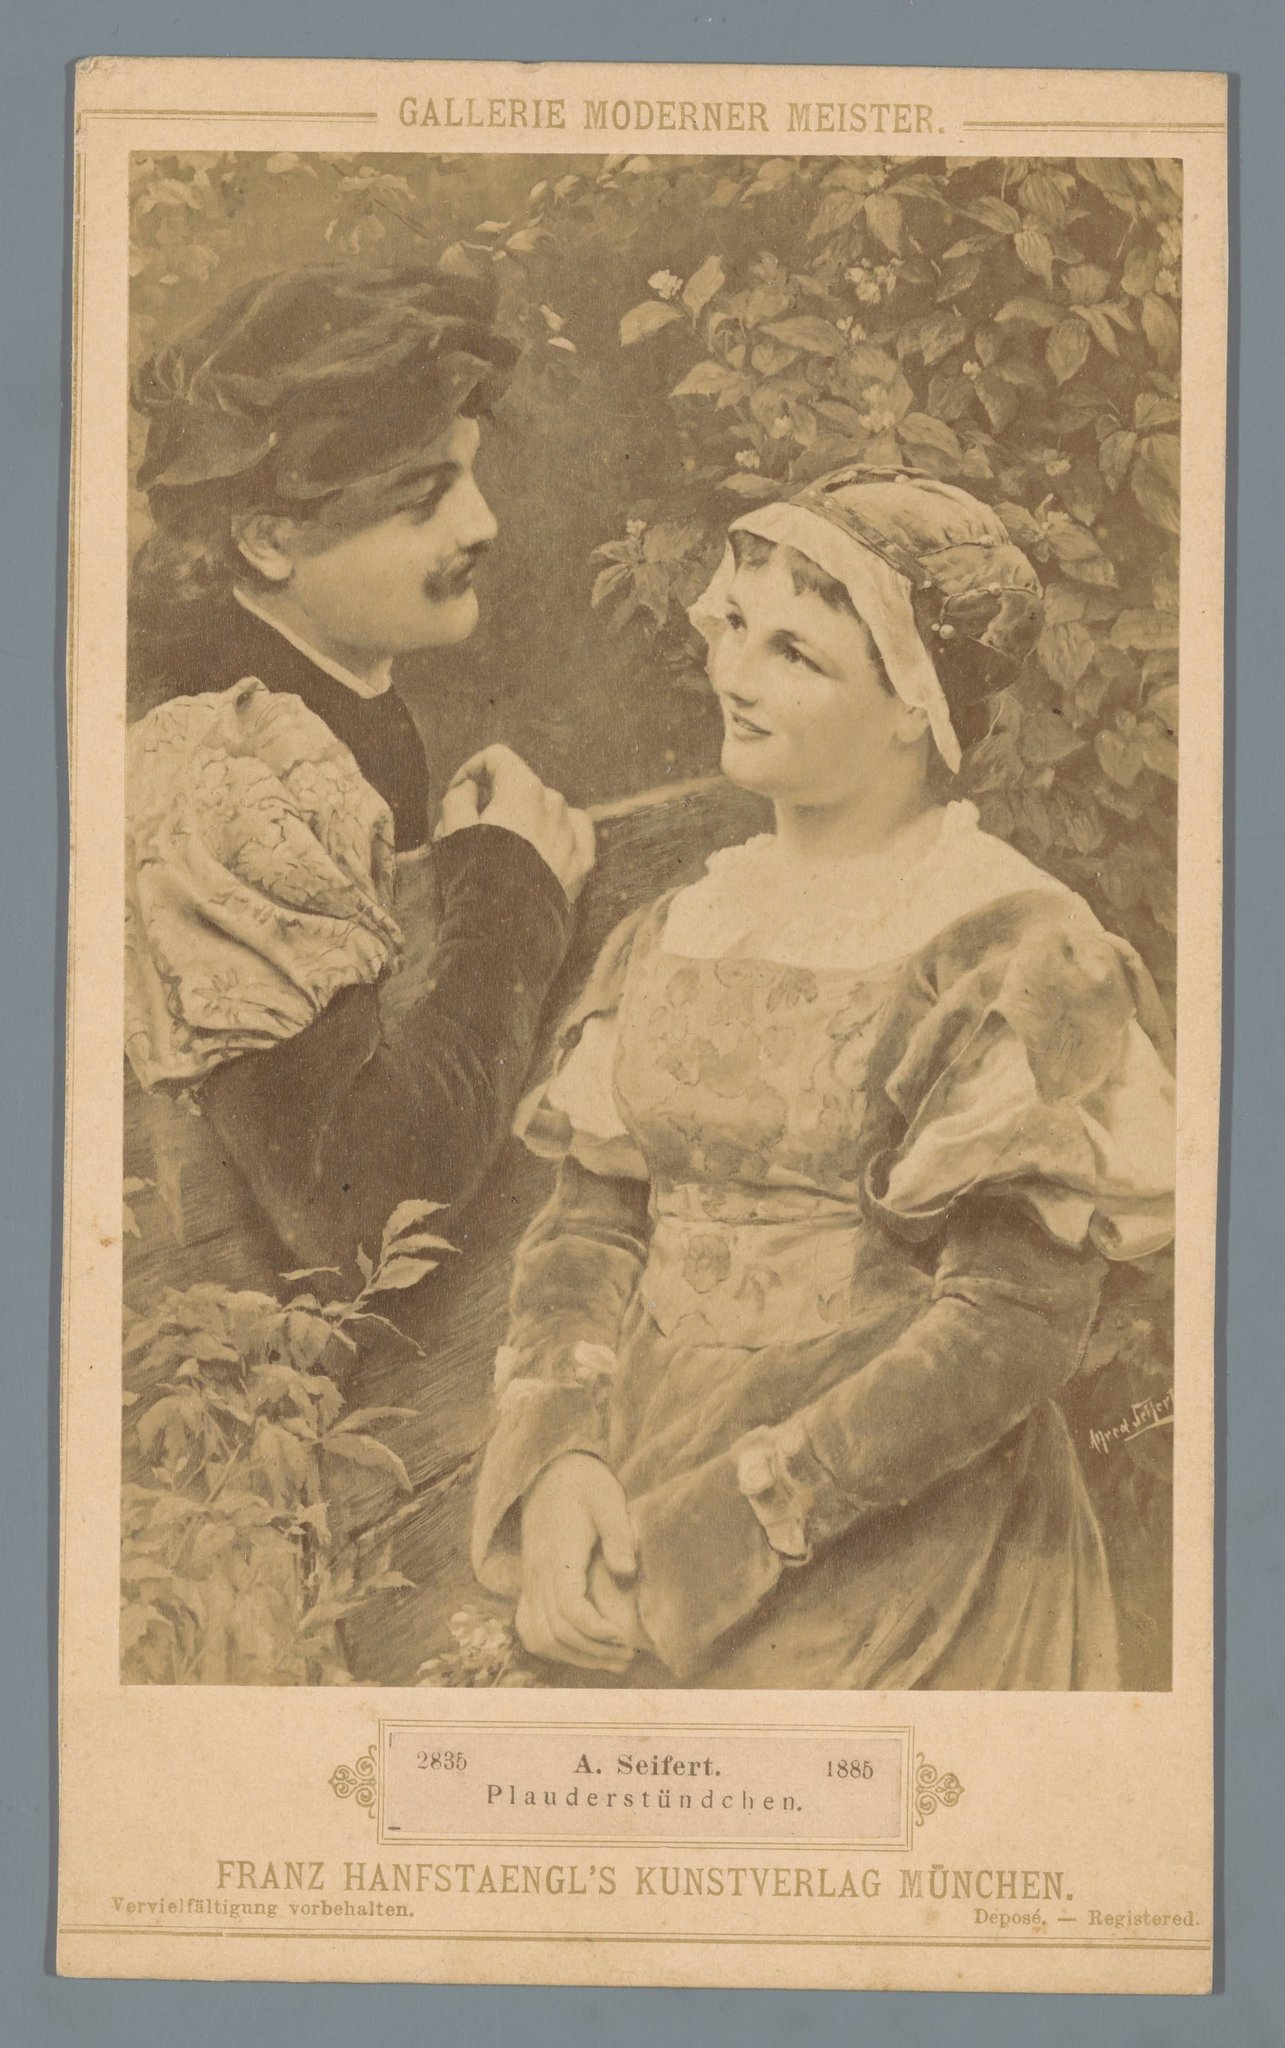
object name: reproduction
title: Gallerie Moderner Meister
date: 1885-1910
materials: cardboard, photographic support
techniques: albumen print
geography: germany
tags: garden, speaking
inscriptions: number: ‘2835’